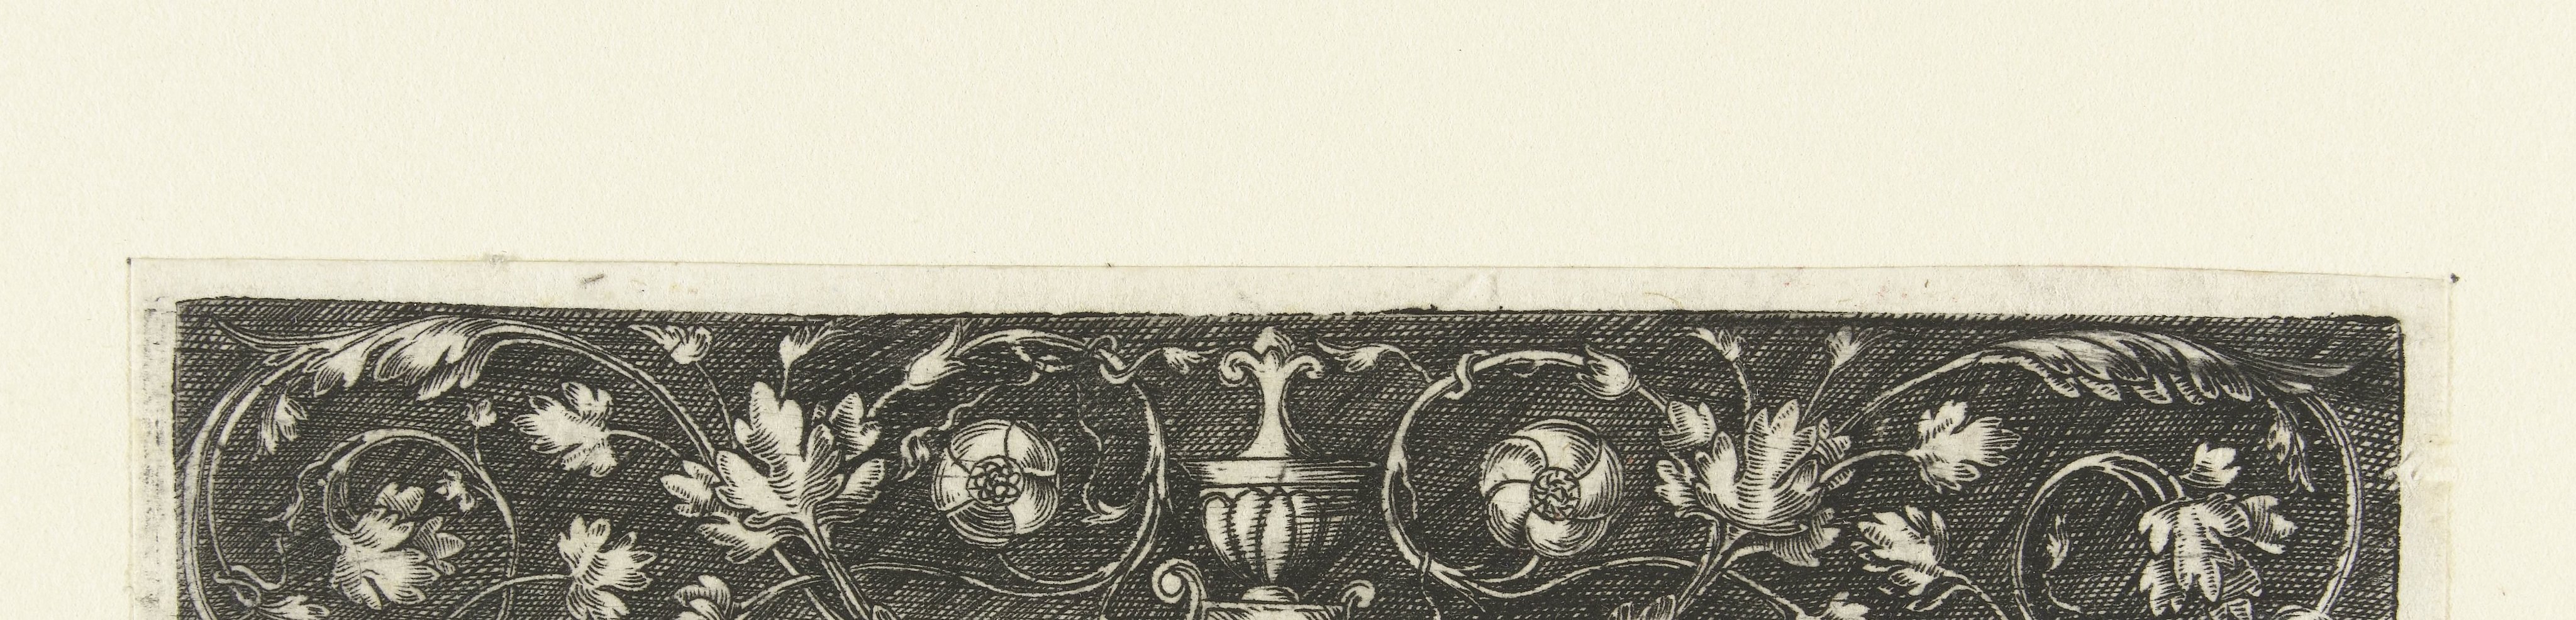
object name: ornament print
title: Twee dubbele voluten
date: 1500-1600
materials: paper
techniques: engraving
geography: germany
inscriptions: collector's mark: Lugt 240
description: Voluten met bladranken en bloemen, ontspruitend aan de voet van een vaas in het midden van het fries. Gearceerde achtergrond. Eén van 11 bladen.